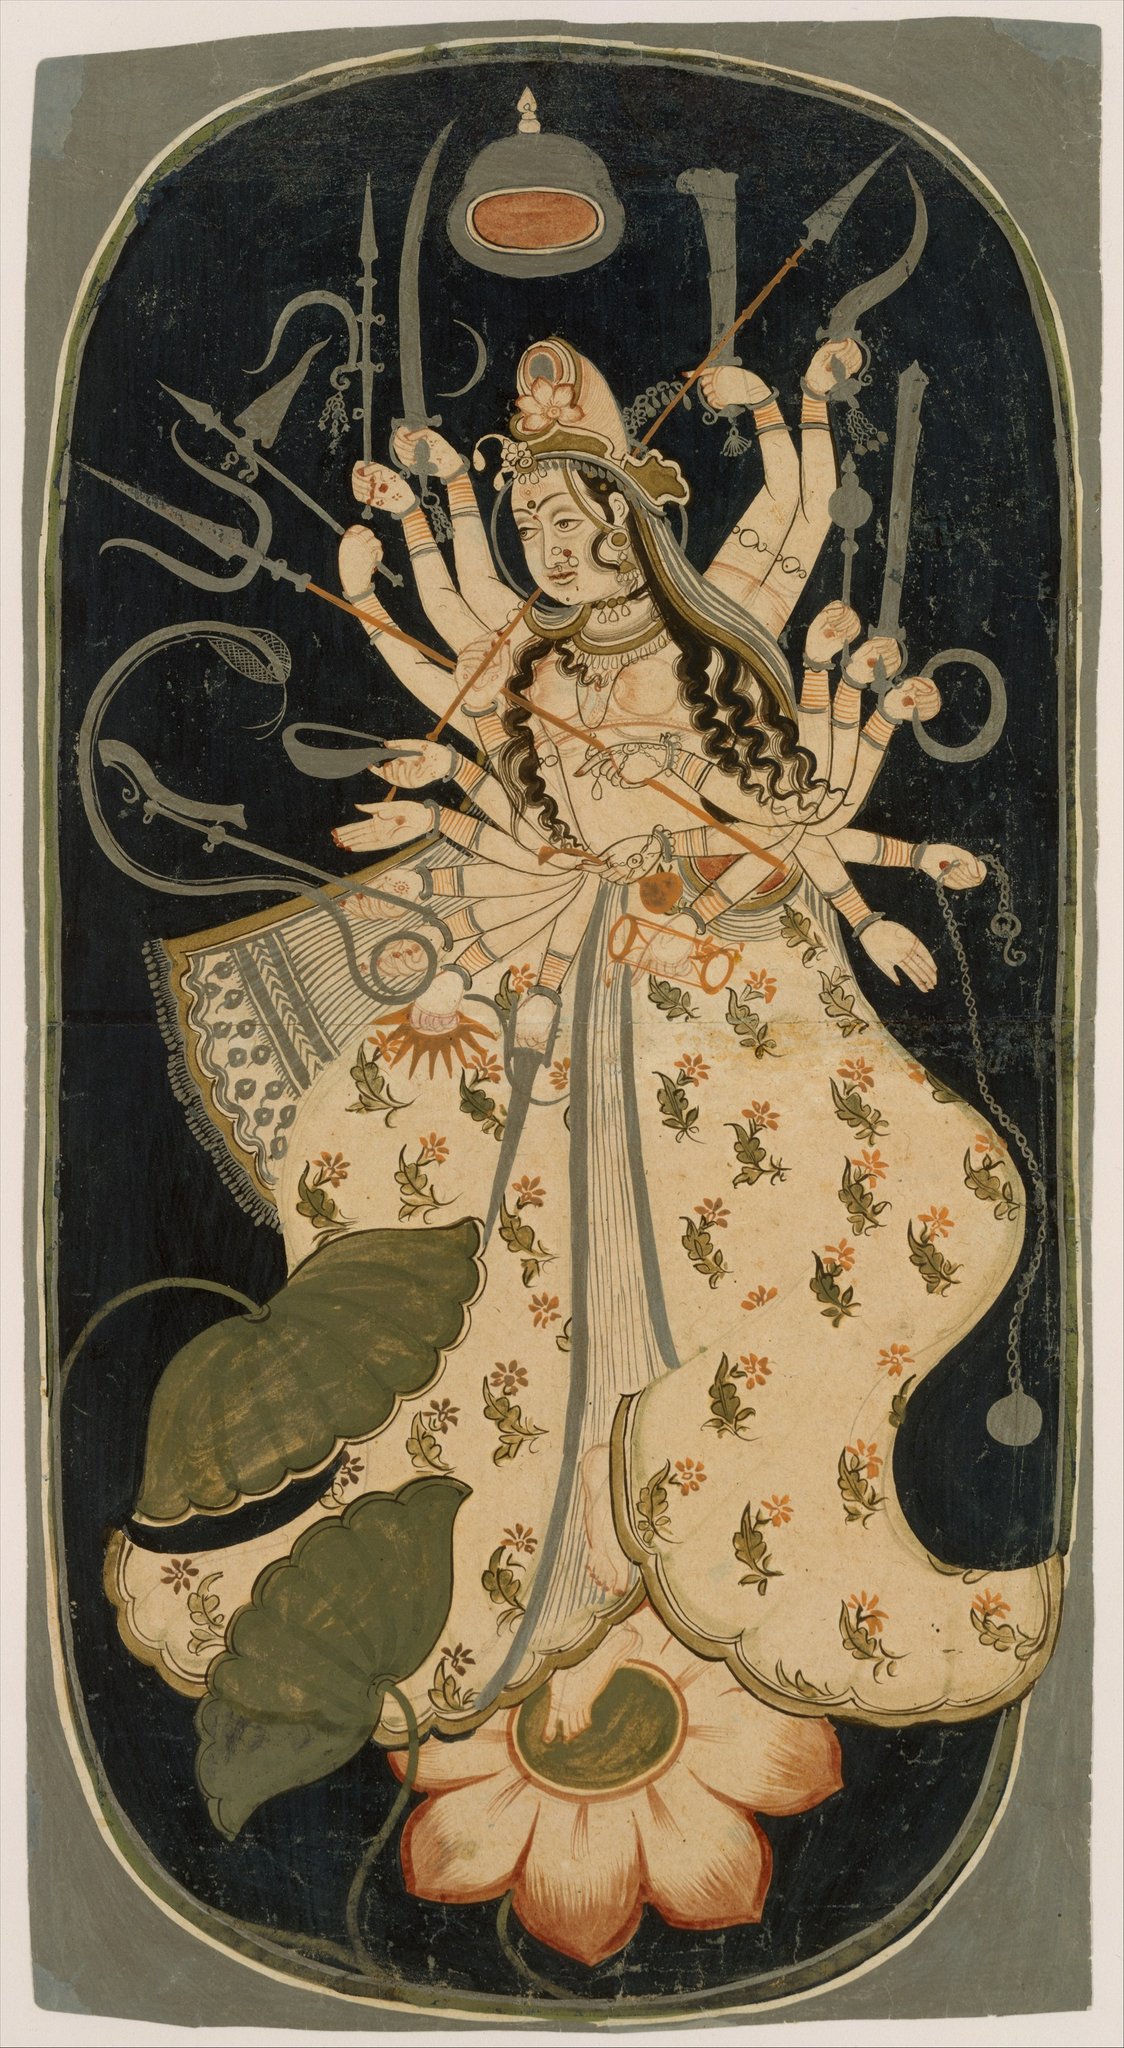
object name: painting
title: Mahadevi, the Great Goddess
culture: indian, rajasthani, bikaner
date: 1725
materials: ink, paper, silver, watercolor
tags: goddess